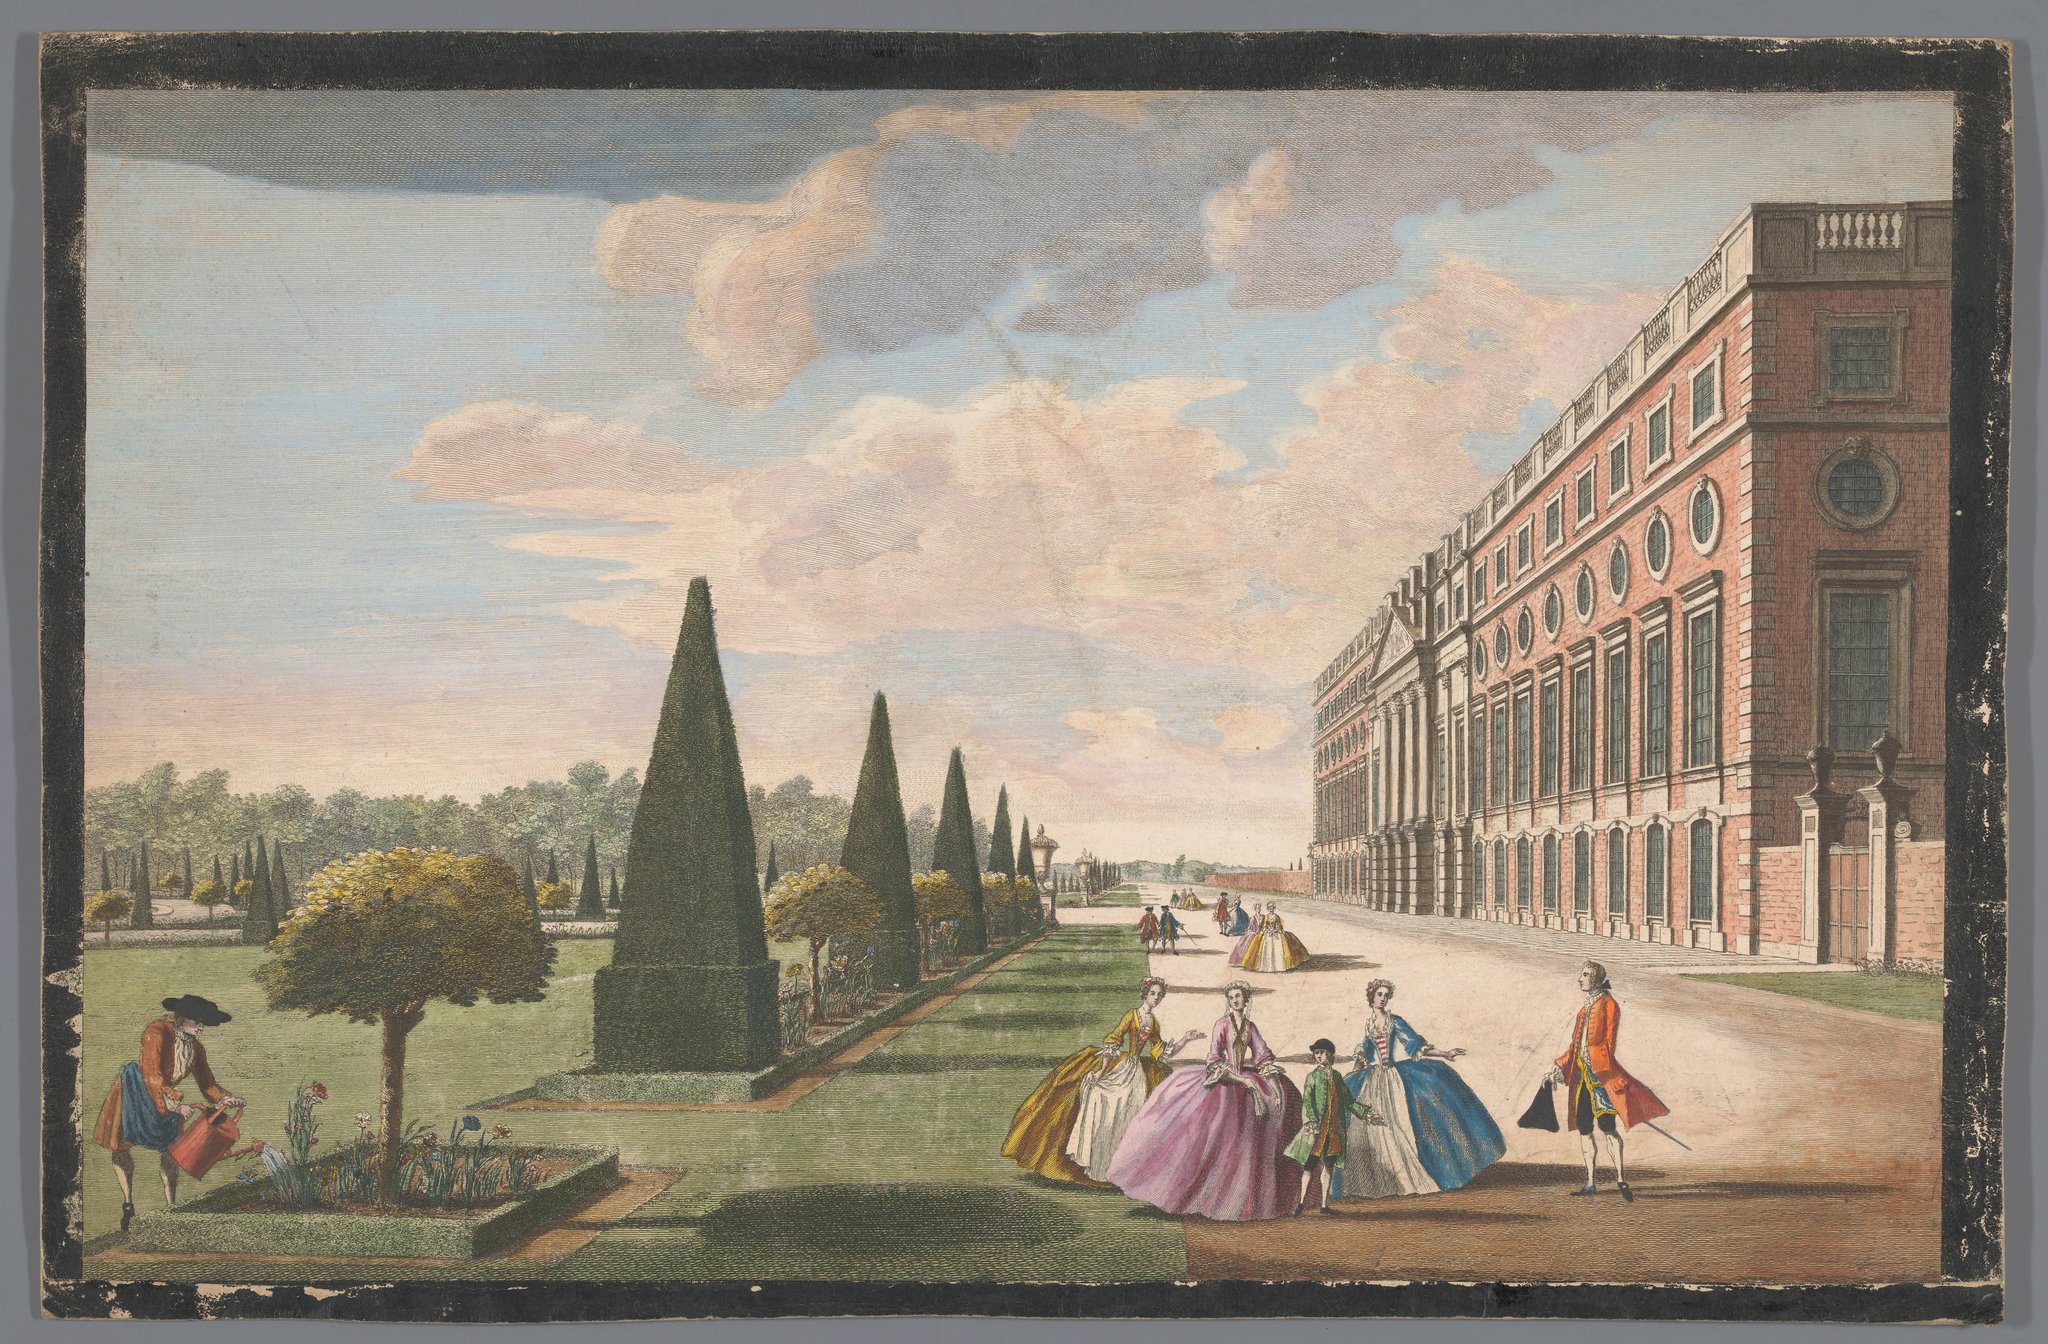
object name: print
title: An oblique perspective view of the east front of Hampton Court, with the long walk & part of the garden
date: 1744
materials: cardboard, paper, watercolor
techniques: brush, etching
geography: london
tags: garden, palace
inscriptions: date